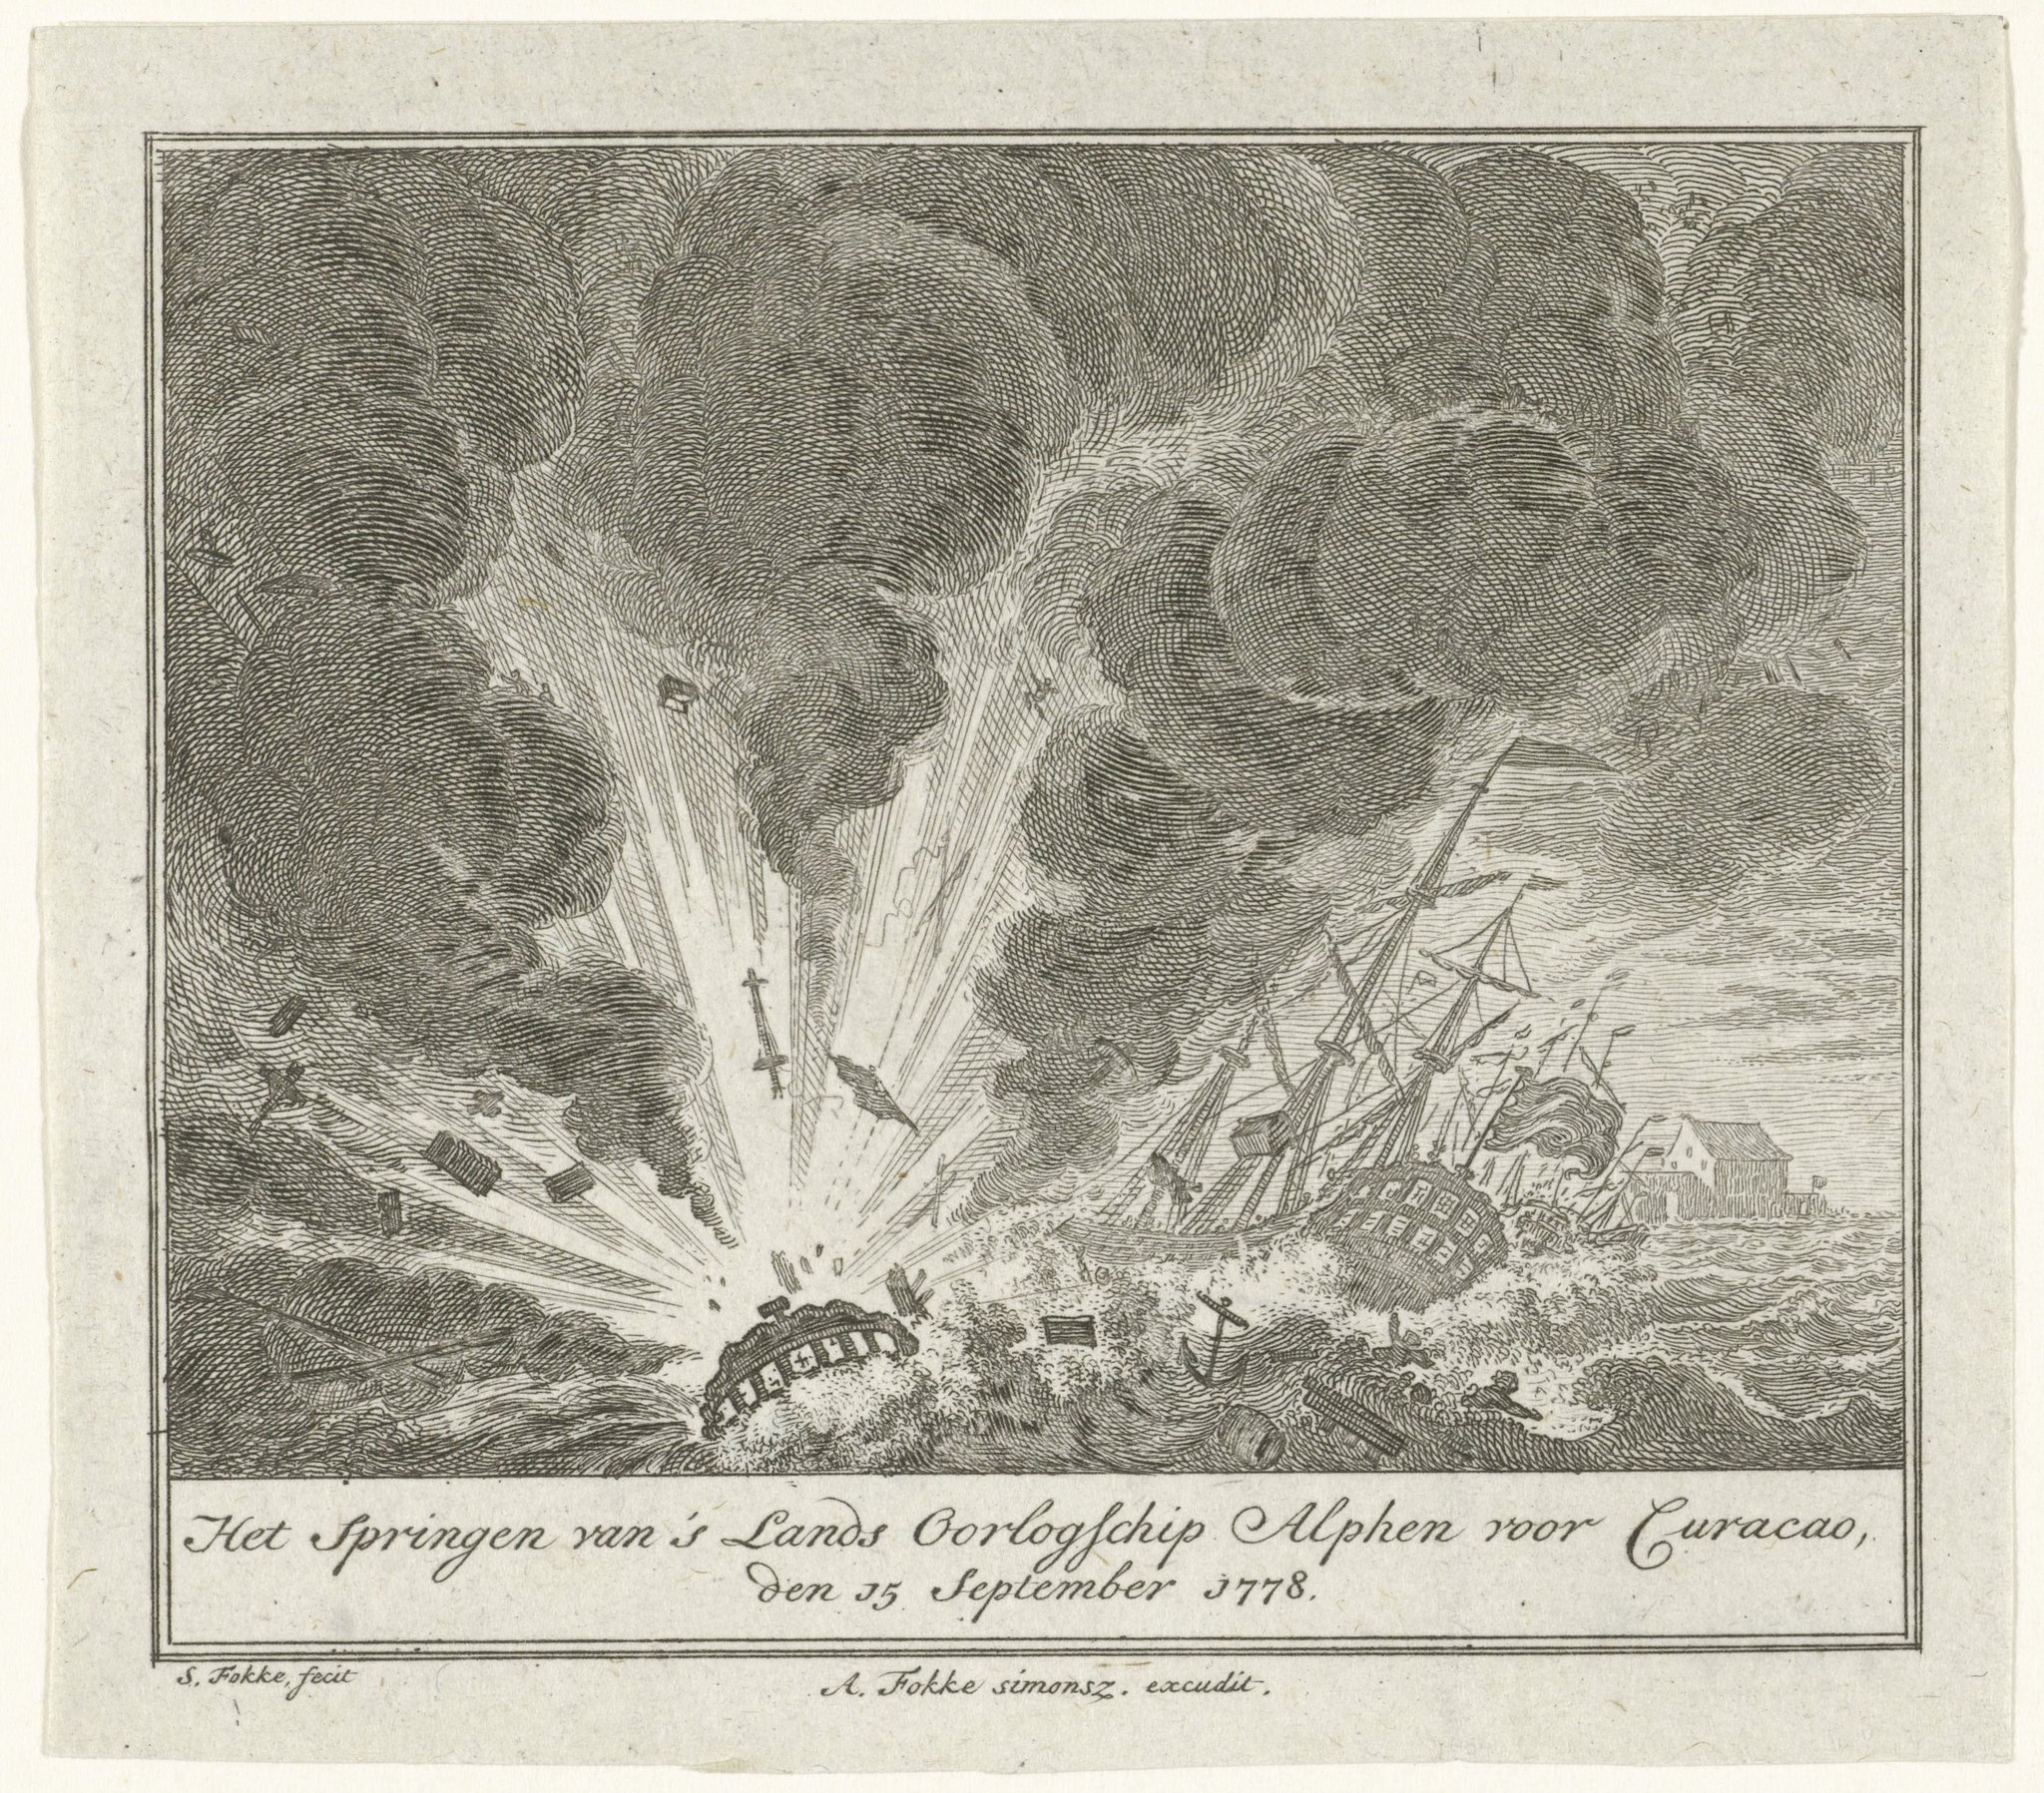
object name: print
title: Het Springen van 's Lands Oorlogschip Alphen voor Curacao, den 15 September 1778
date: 1778-1779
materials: paper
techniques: engraving, etching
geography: northern netherlands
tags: gunpowder disaster (+ sailing-ships)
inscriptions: collector's mark: Lugt 2228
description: Het ontploffen van het fregat Alphen met de volledige bemanning van 206 man in de haven van Willemstad aan de St. Annabaai te Curaçao, 15 september 1778. Een explosie rijt het schip in stukken.